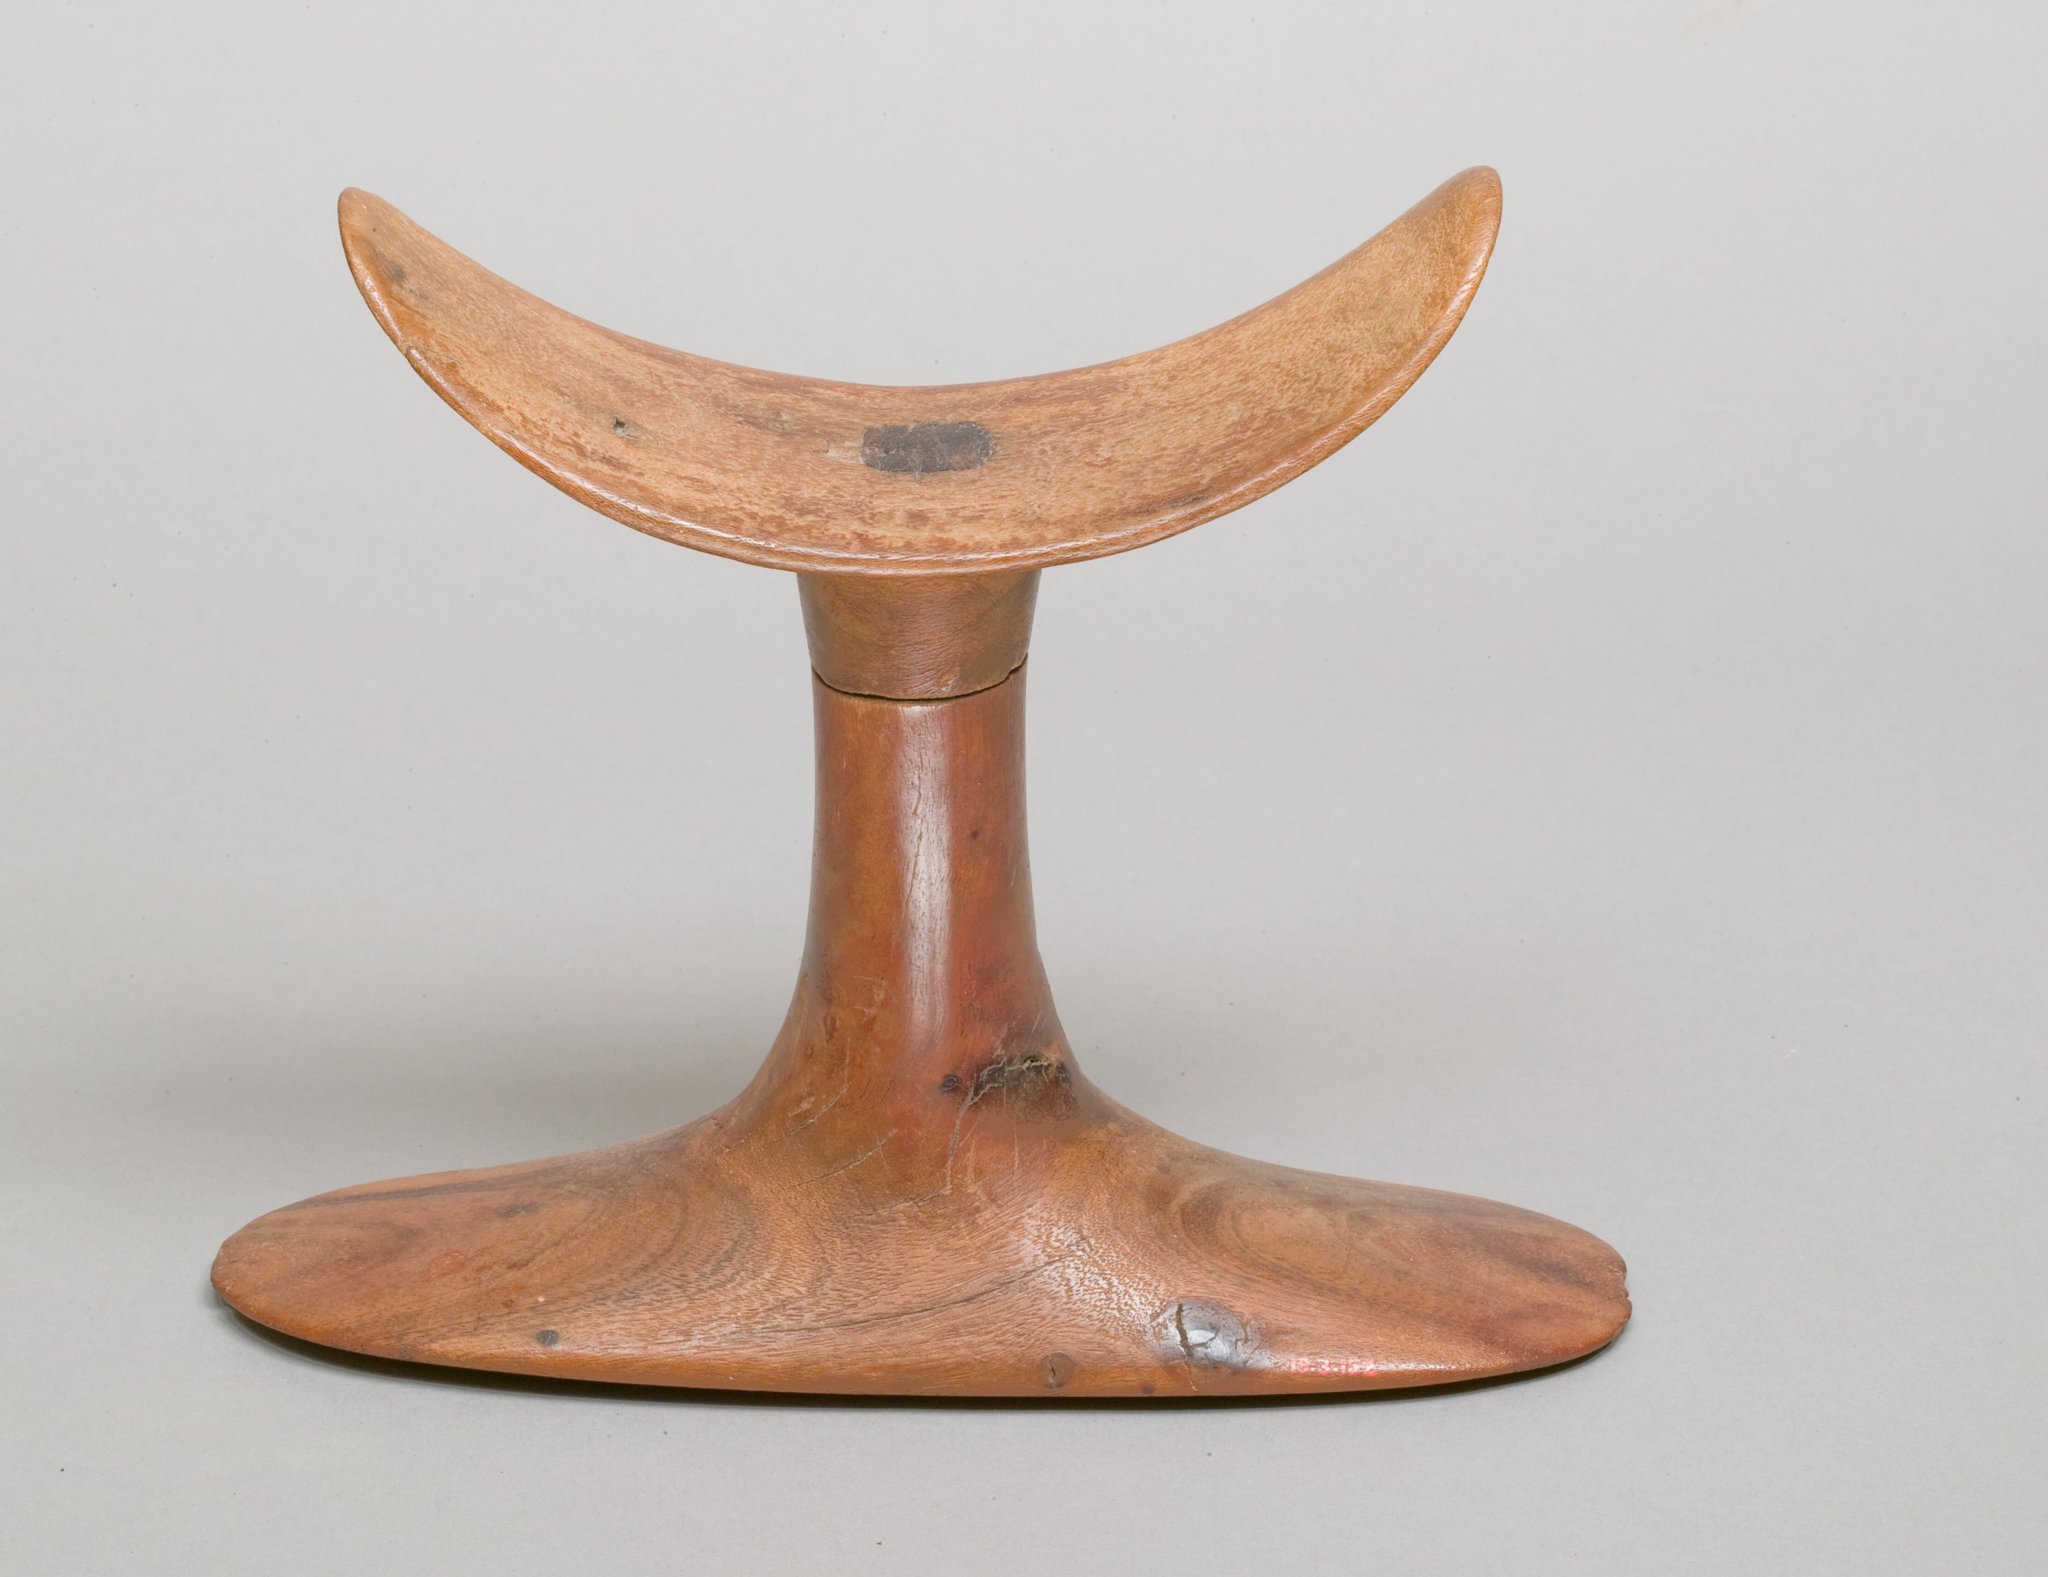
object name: headrest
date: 2030-1640 BCE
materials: wood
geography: egypt